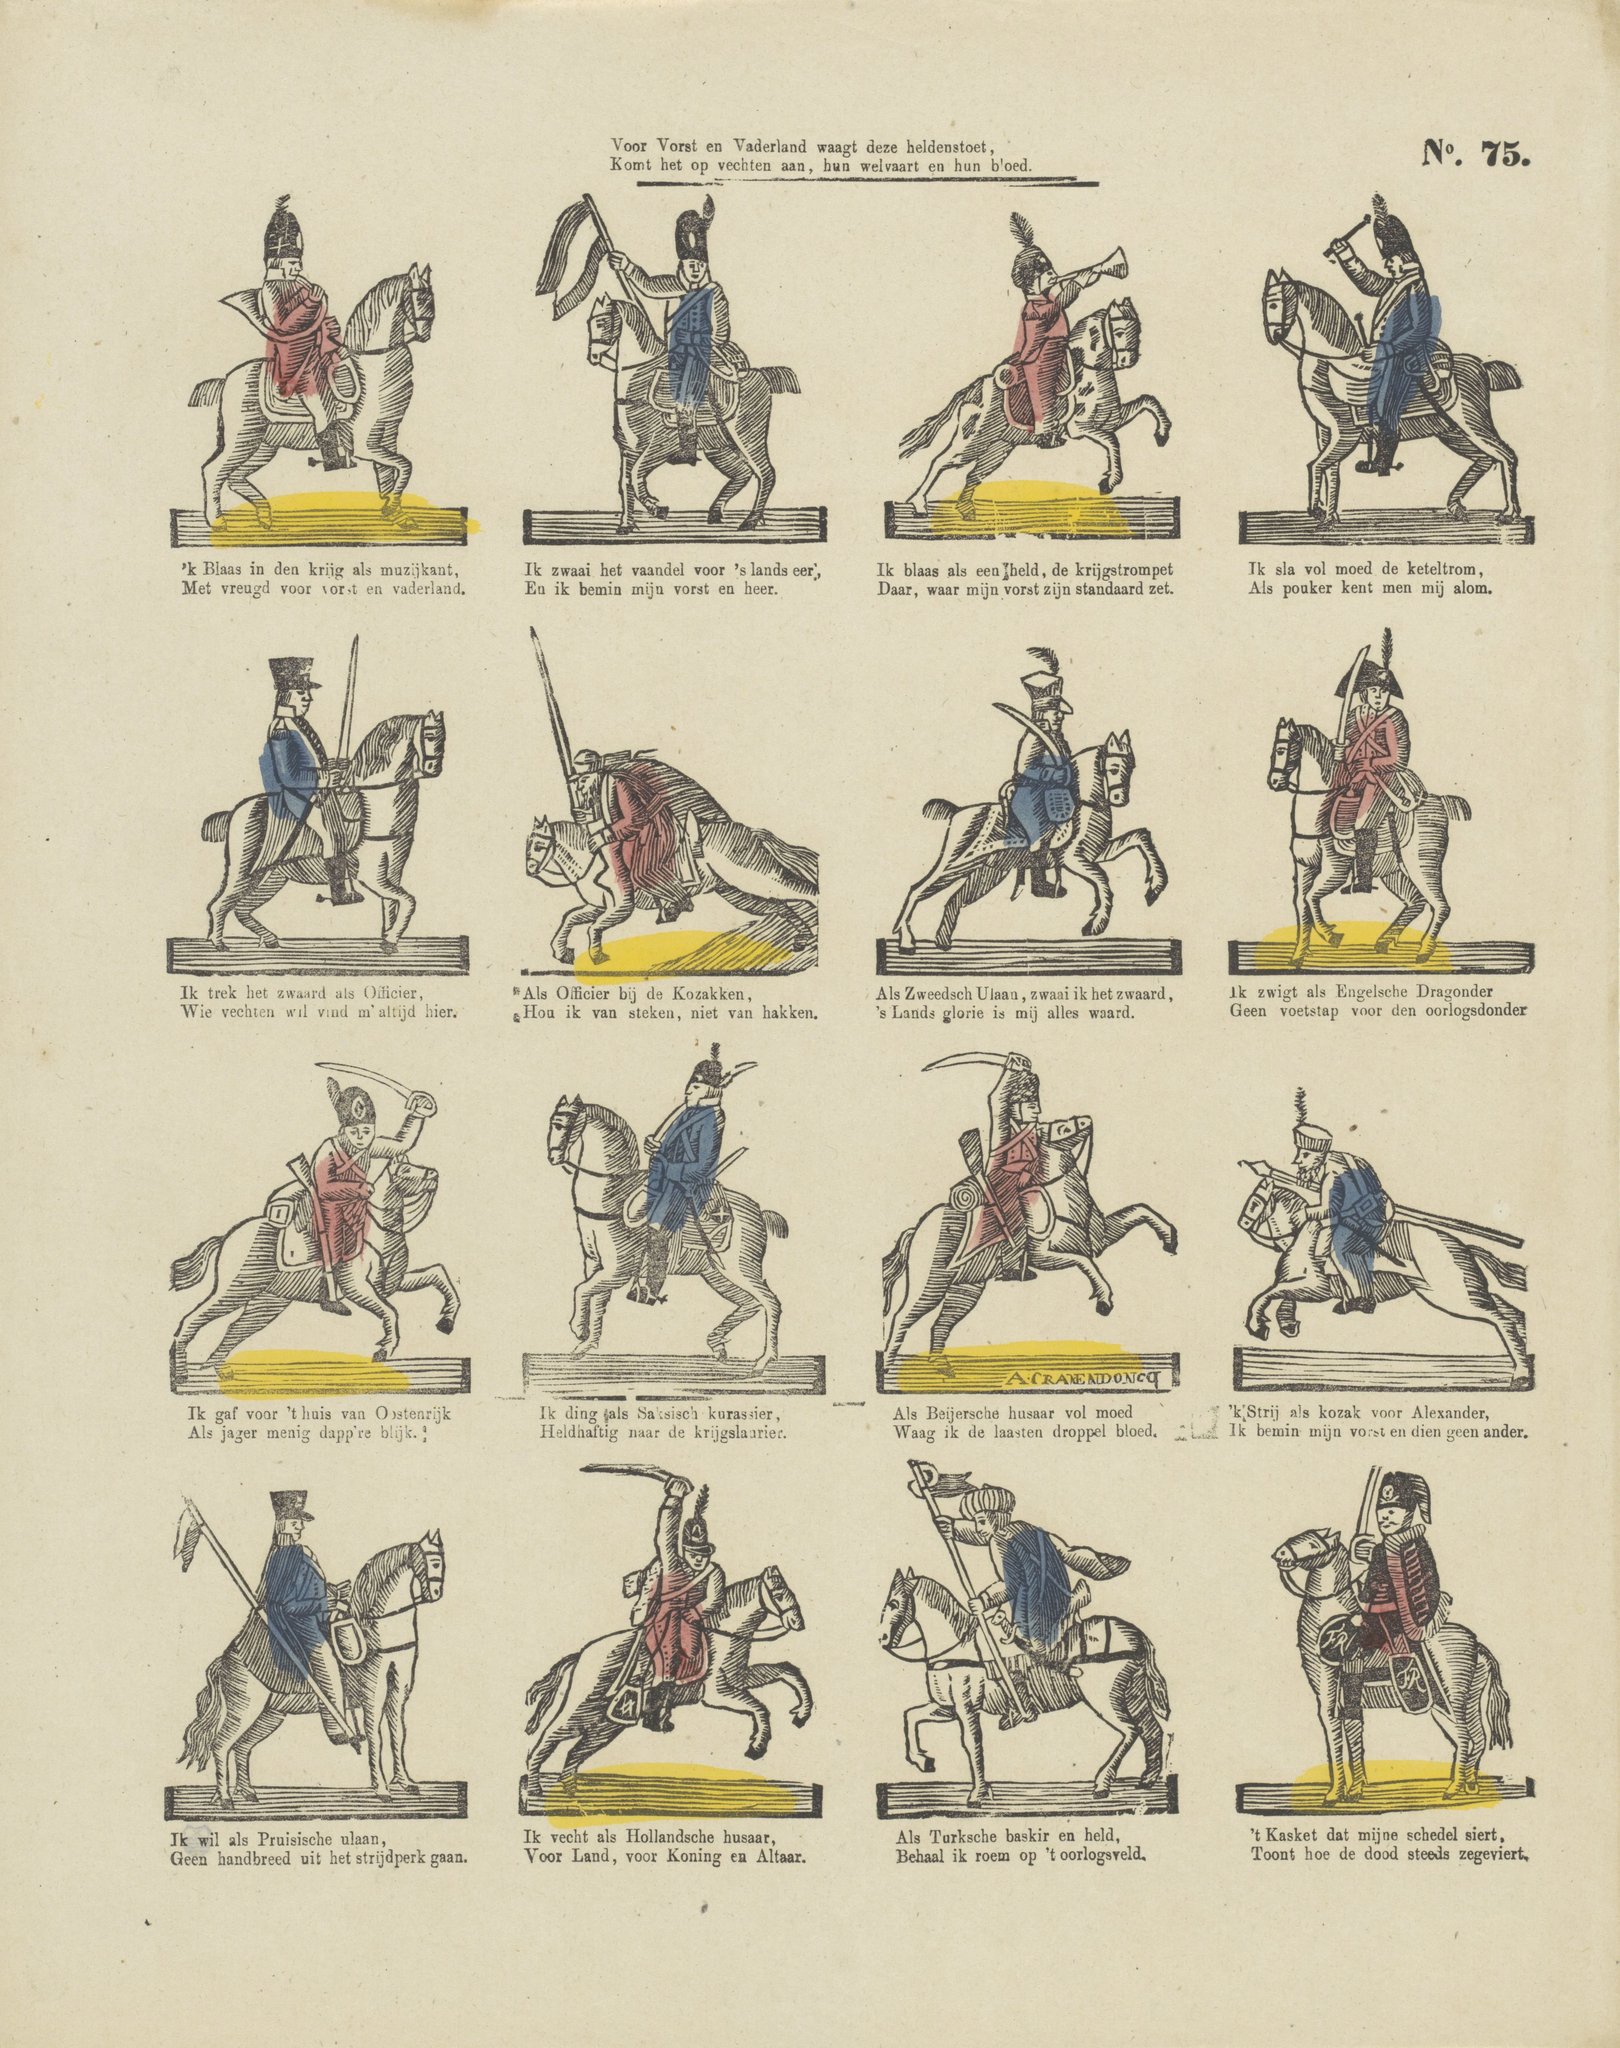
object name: popular print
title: Voor vorst en vaderland waagt deze heldenstoet, / Komt het op vechten aan, hun welvaart en hun bloed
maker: alexander cranendoncq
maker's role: draughtsman, print maker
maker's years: 1799-1869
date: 1850-1870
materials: paper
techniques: colour, letterpress printing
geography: netherlands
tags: warfare; military affairs (+ cavalry, horsemen), the soldier; the soldier's life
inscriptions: collector's mark: Lugt 2760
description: Blad met 16 voorstellingen van militairen te paard. Onder elke voorstelling een tweeregelig vers. Genummerd rechtsboven: No. 75.